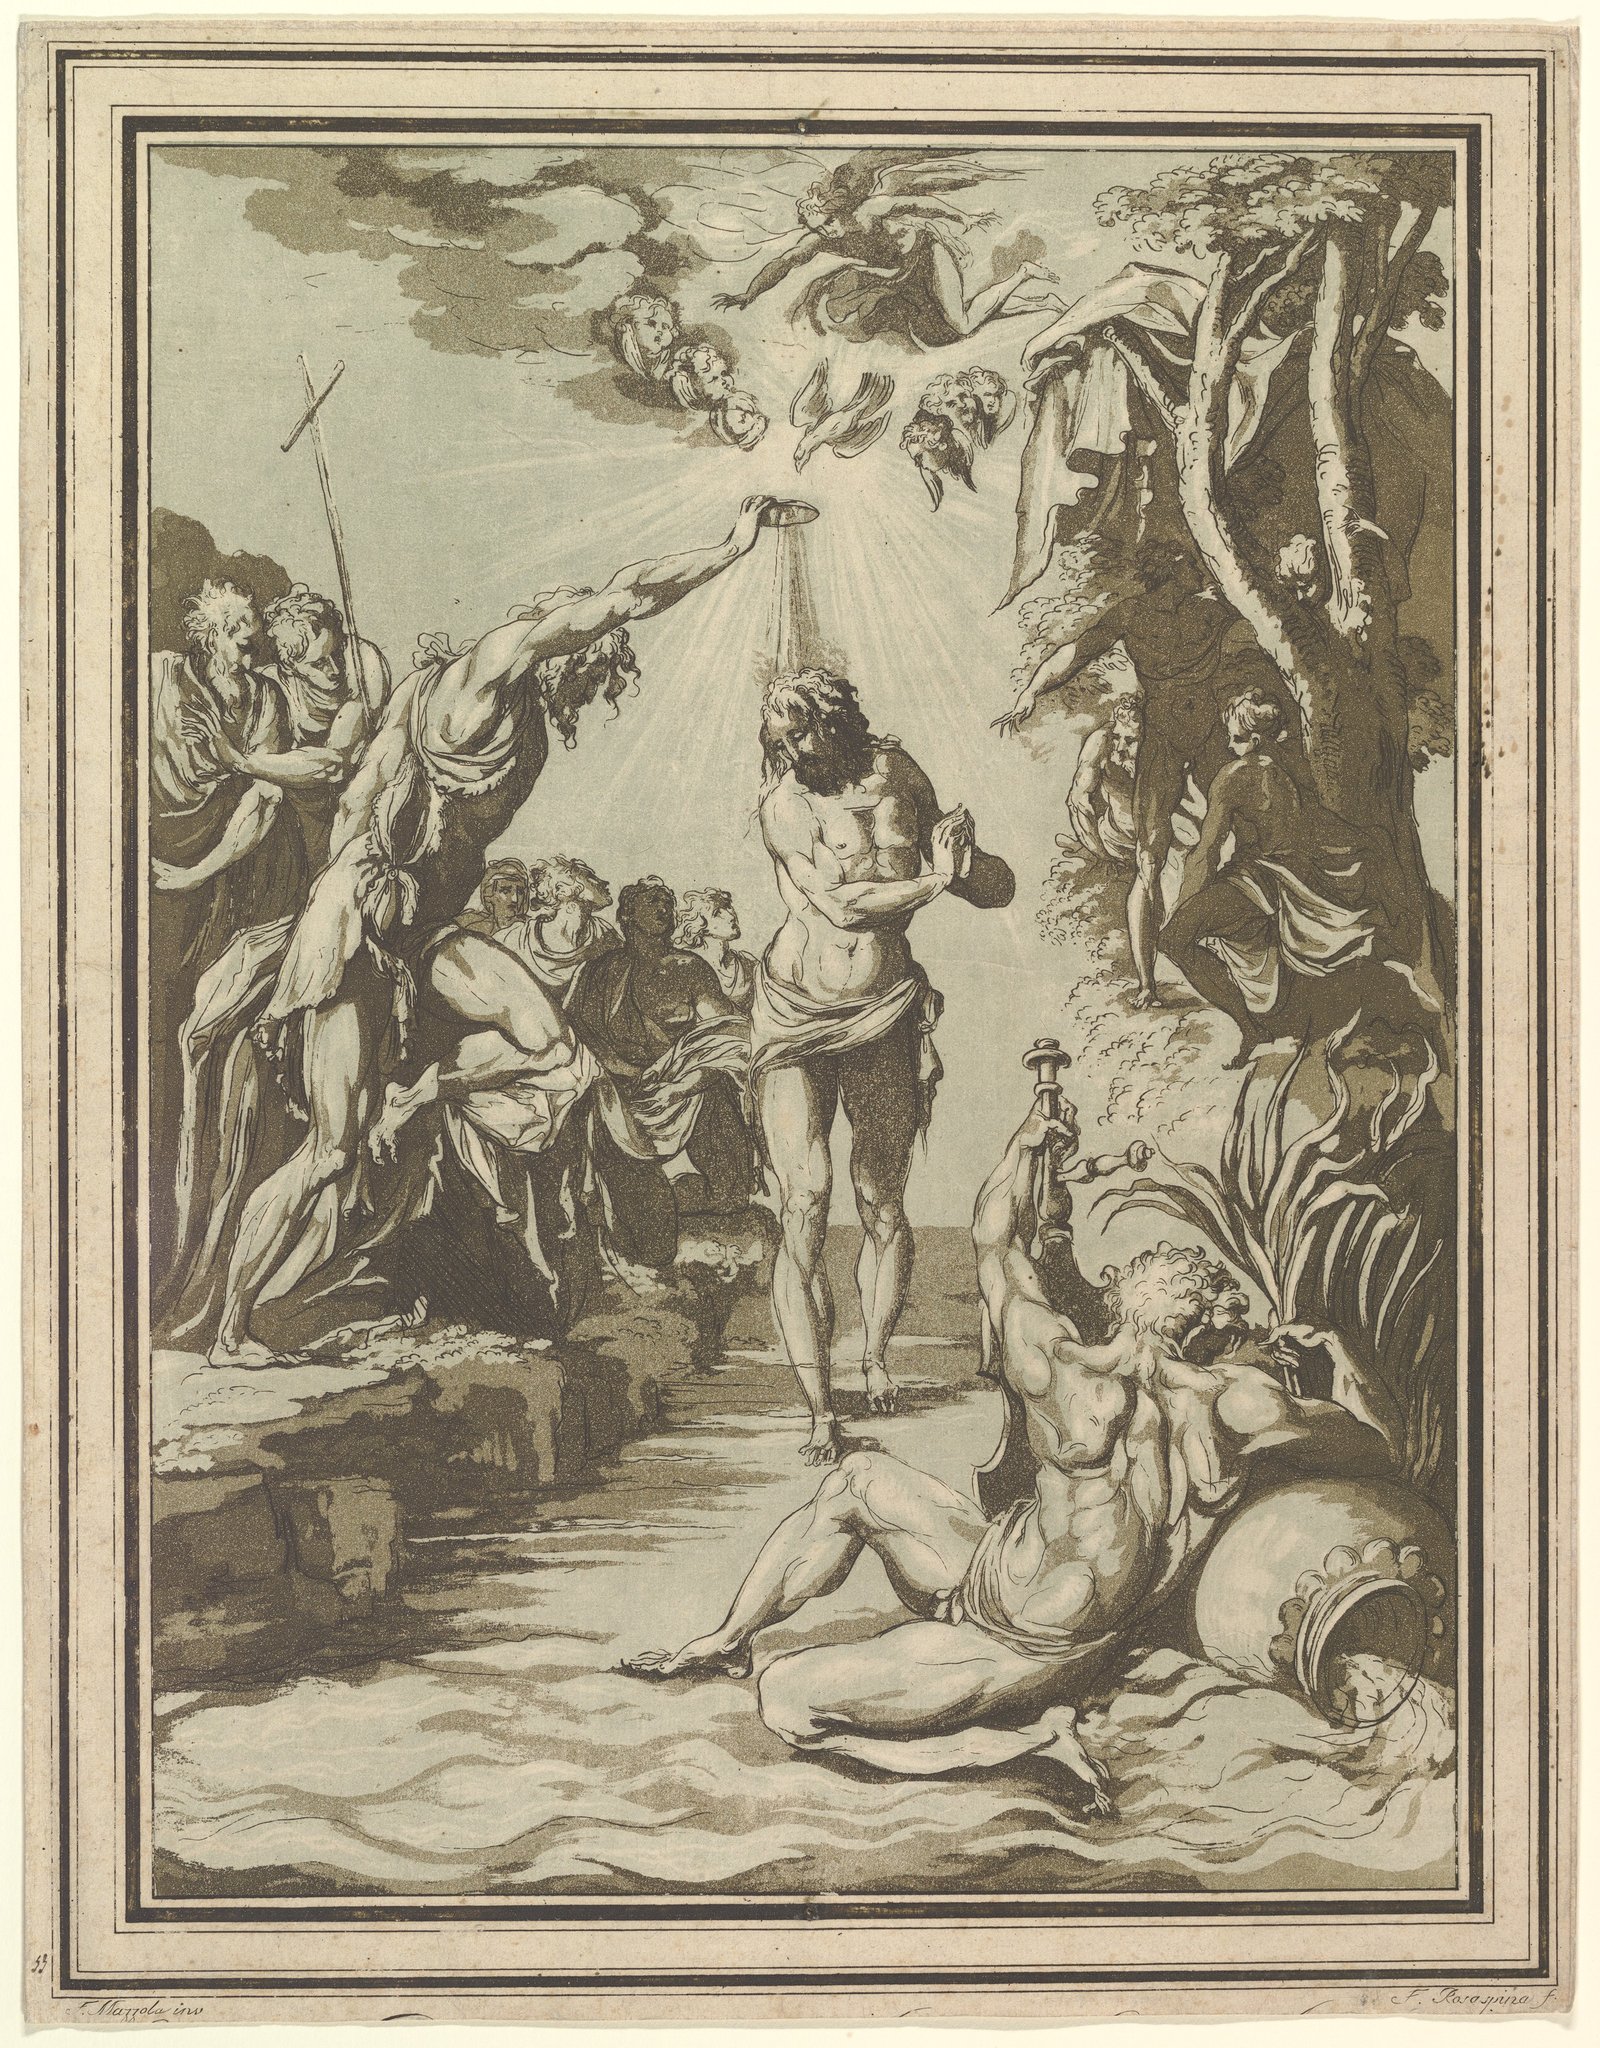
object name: print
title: Baptism of Christ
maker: francesco rosaspina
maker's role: artist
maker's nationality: italian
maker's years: 1762-1841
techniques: aquatint, etching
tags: christ,cross,baptism of christ